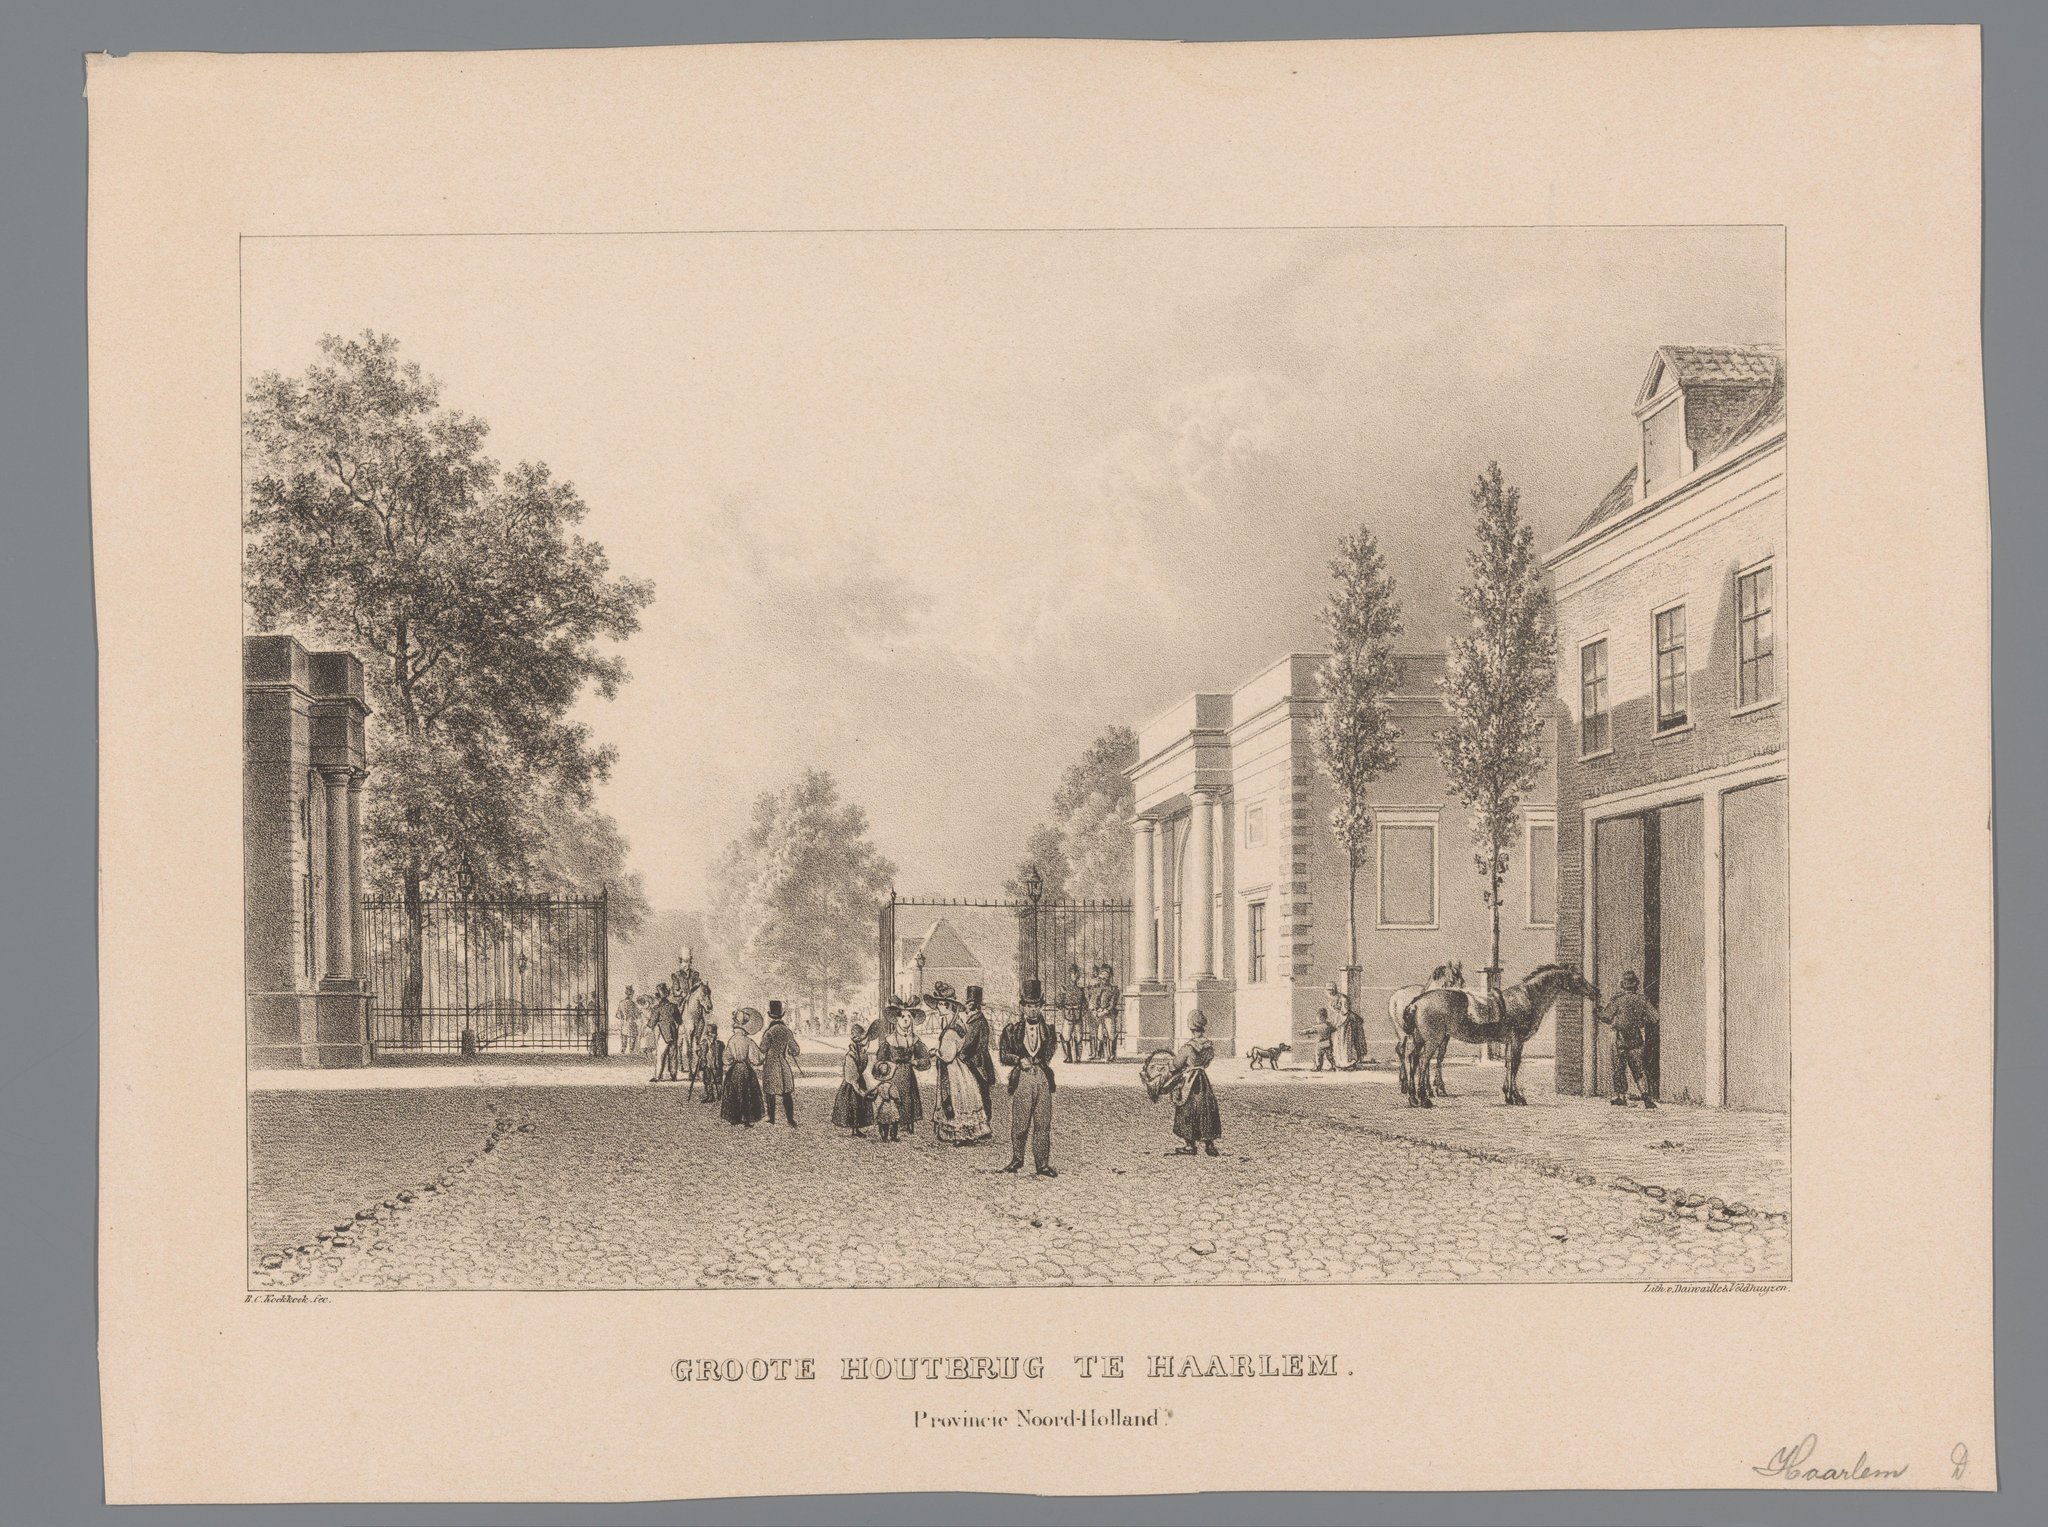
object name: print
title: Groote Houtbrug te Haarlem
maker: barend cornelis koekkoek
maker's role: draughtsman, painter, print maker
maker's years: 1803-1862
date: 1831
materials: paper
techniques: lithograph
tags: toll gate, street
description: Links en rechts van de poort commiezenhuizen waar door ambtenaren tol werd geheven bij het binnengaan van de stad. Op straat lopen figuren.